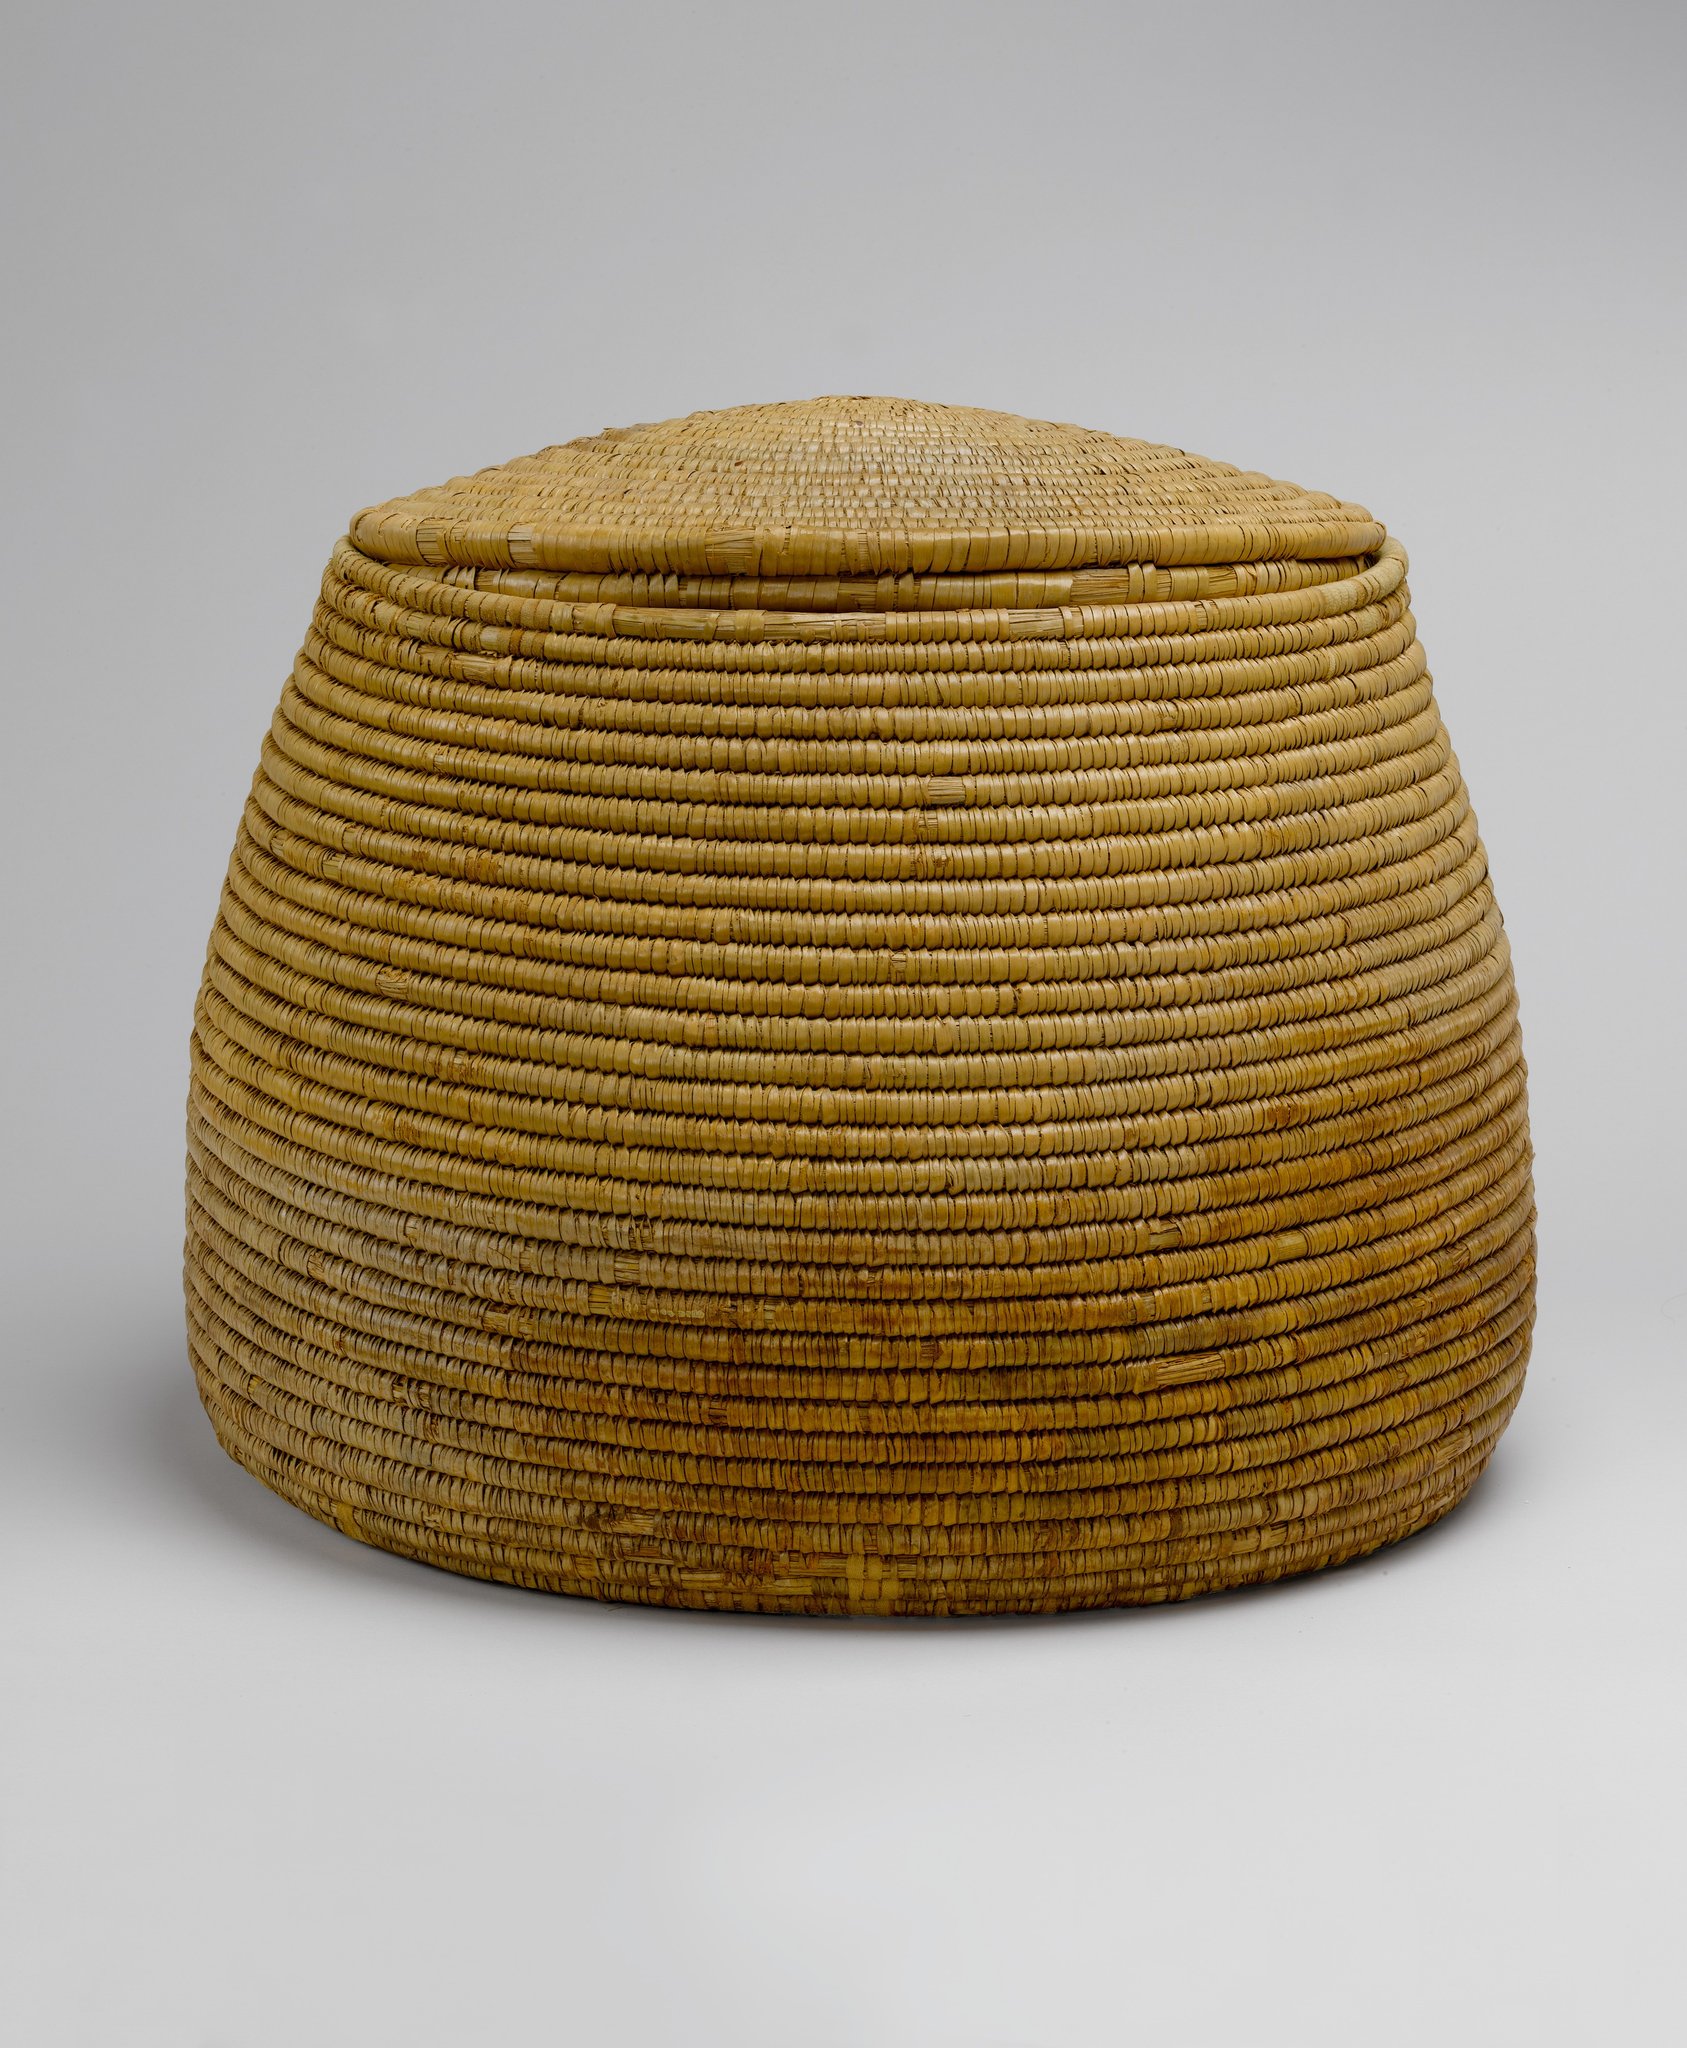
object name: basket, lid, maritamun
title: Basket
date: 1525-1504 BCE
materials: leaf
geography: egypt